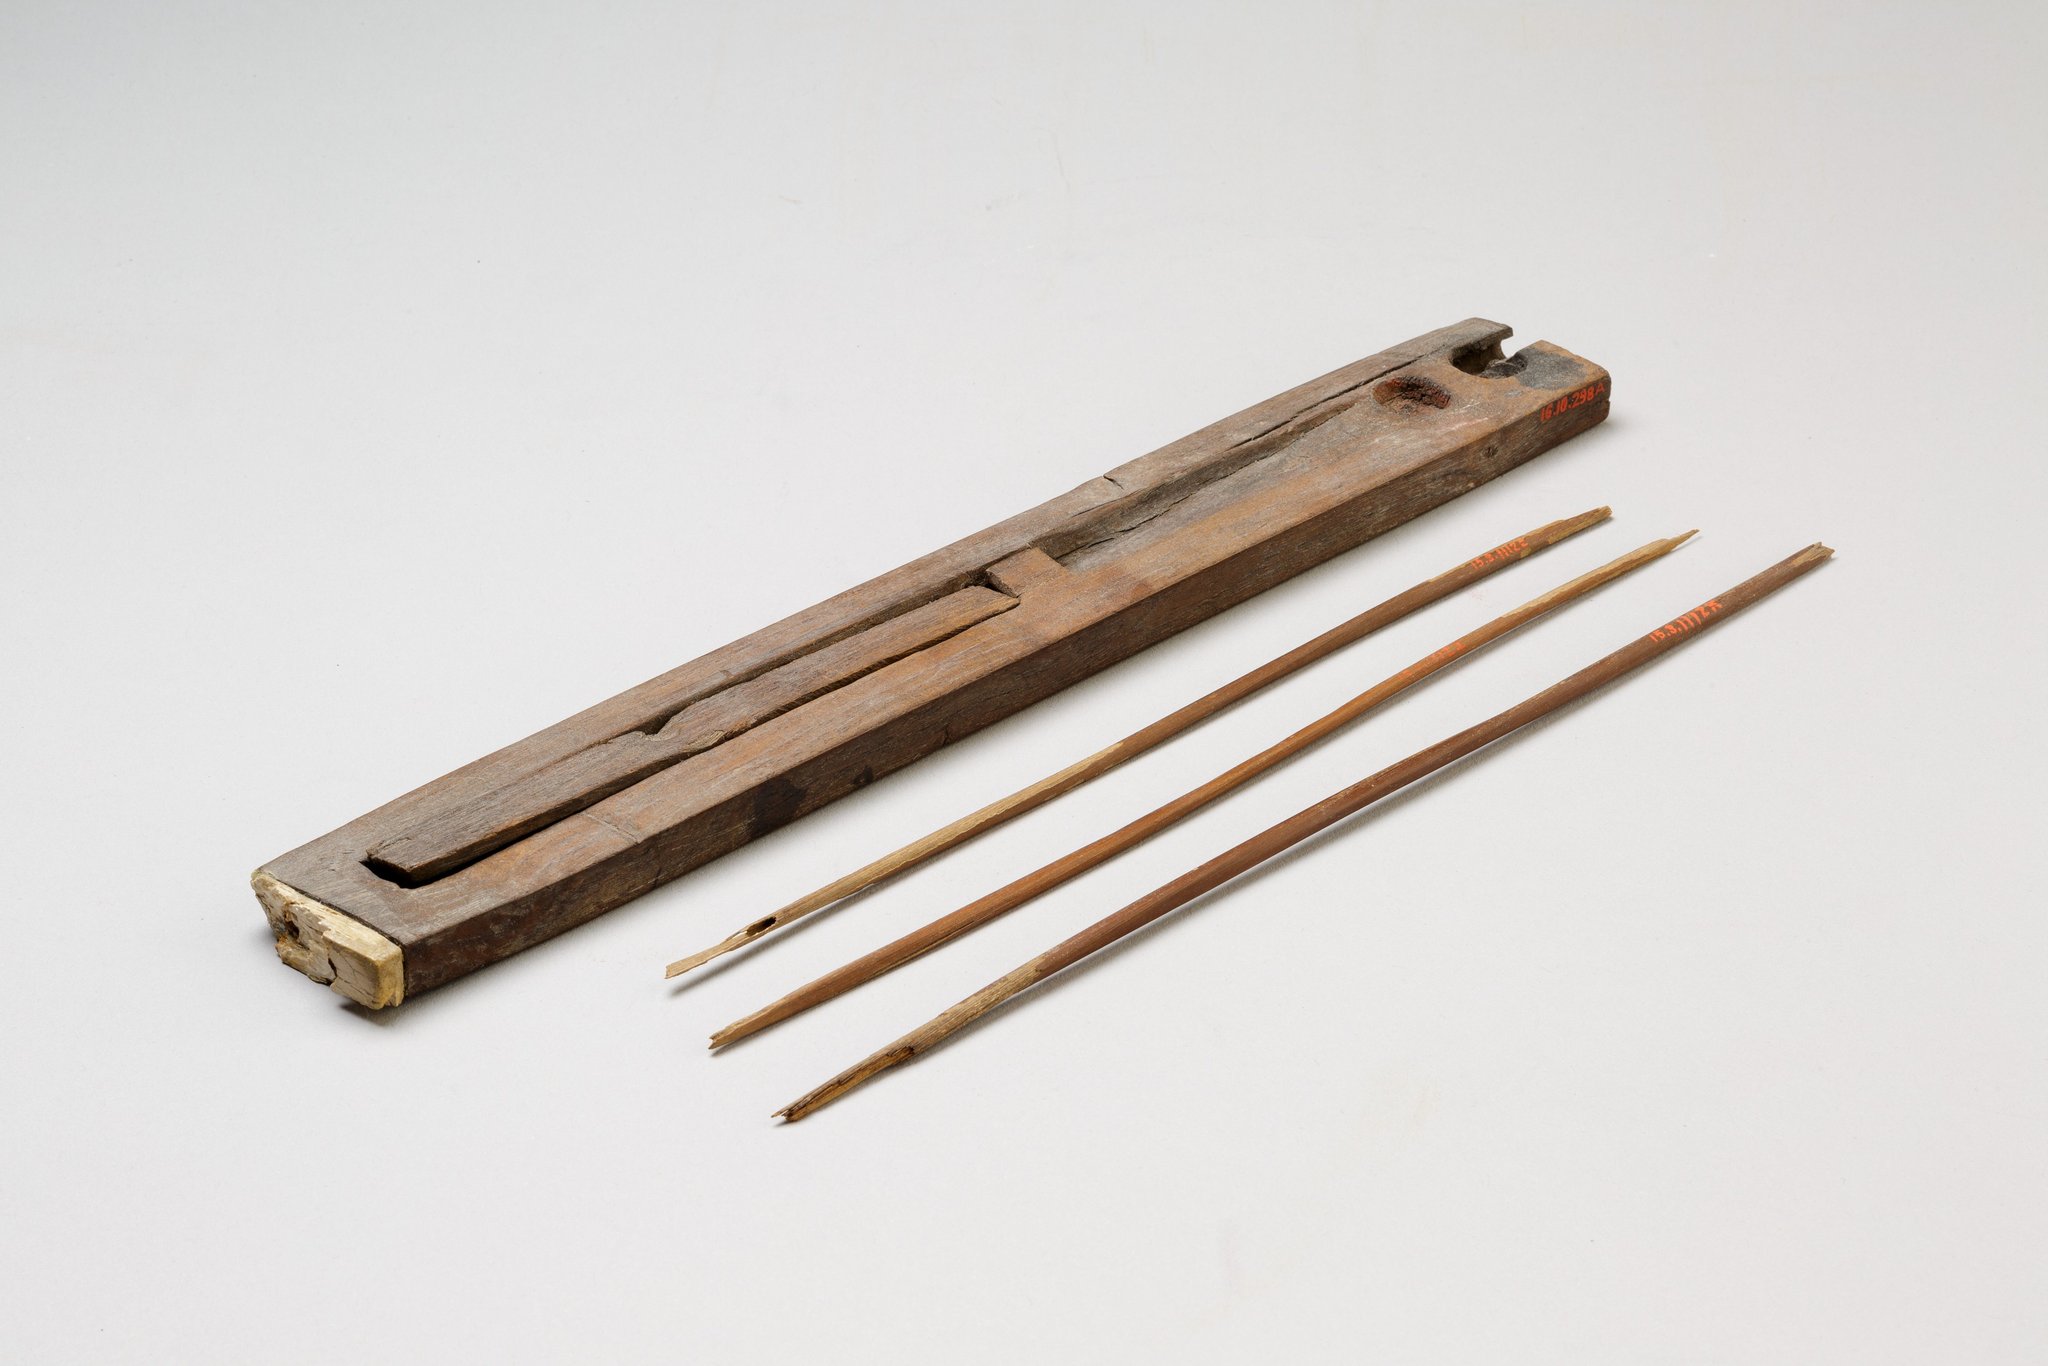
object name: brush 3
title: Three Scribe's Brushes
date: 1981-1640 BCE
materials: wood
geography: egypt